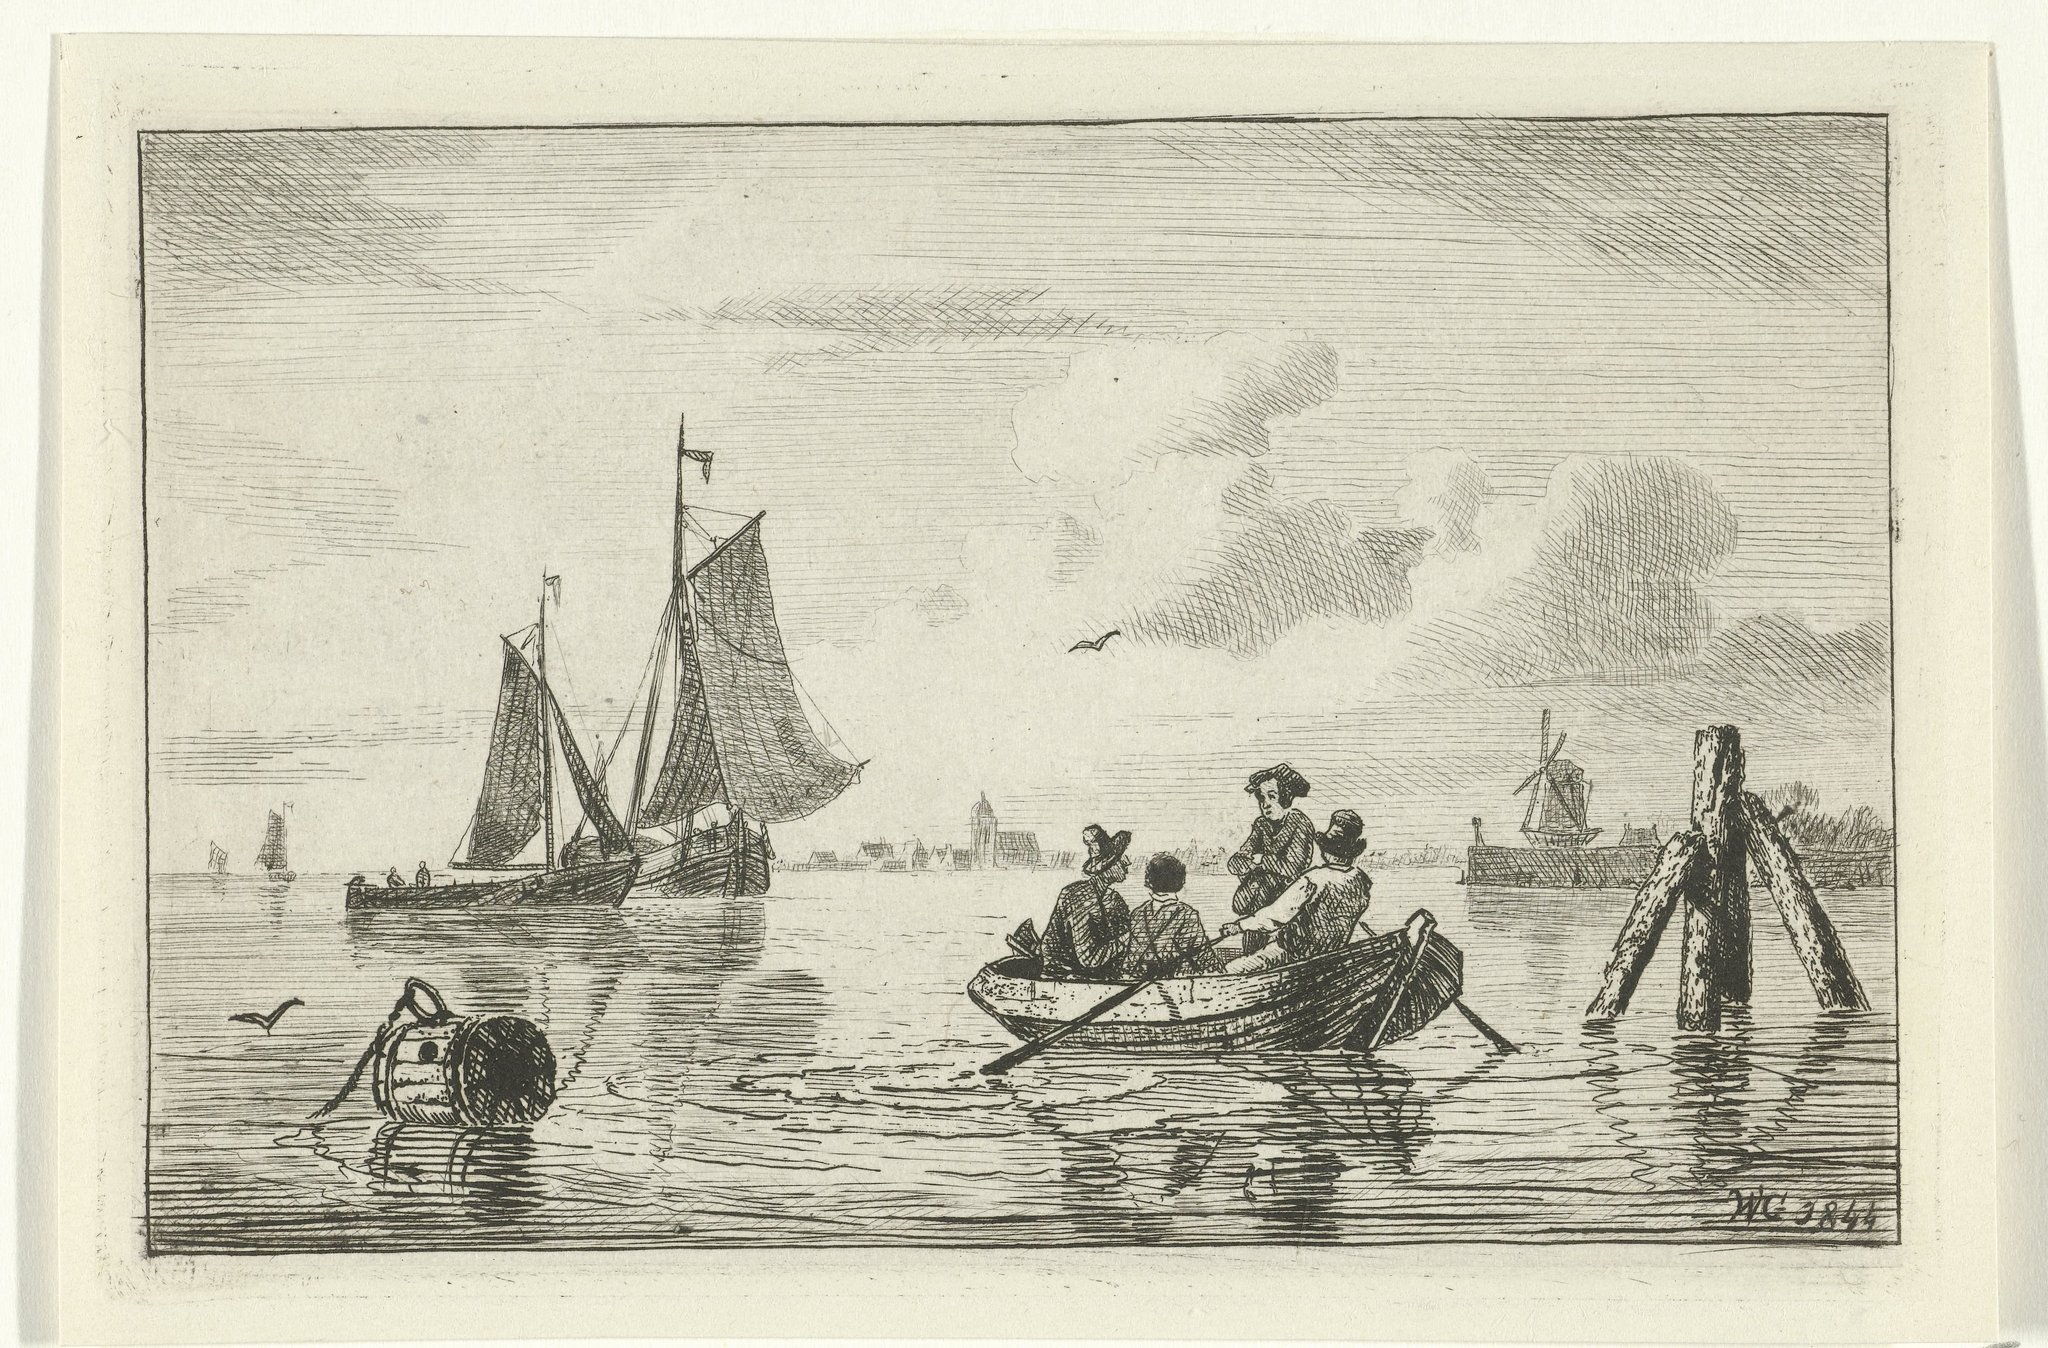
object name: print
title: Vier mannen in sloep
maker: willem gruyter jr.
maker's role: draughtsman, print maker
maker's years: 1817-1880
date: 1844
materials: paper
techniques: etching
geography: amsterdam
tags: rowing-boat, canoe, etc.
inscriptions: collector's mark: Lugt 2165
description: Vier mannen in een sloep. Op de voorgrond een boei; op de achtergrond een molen en zeilschepen.